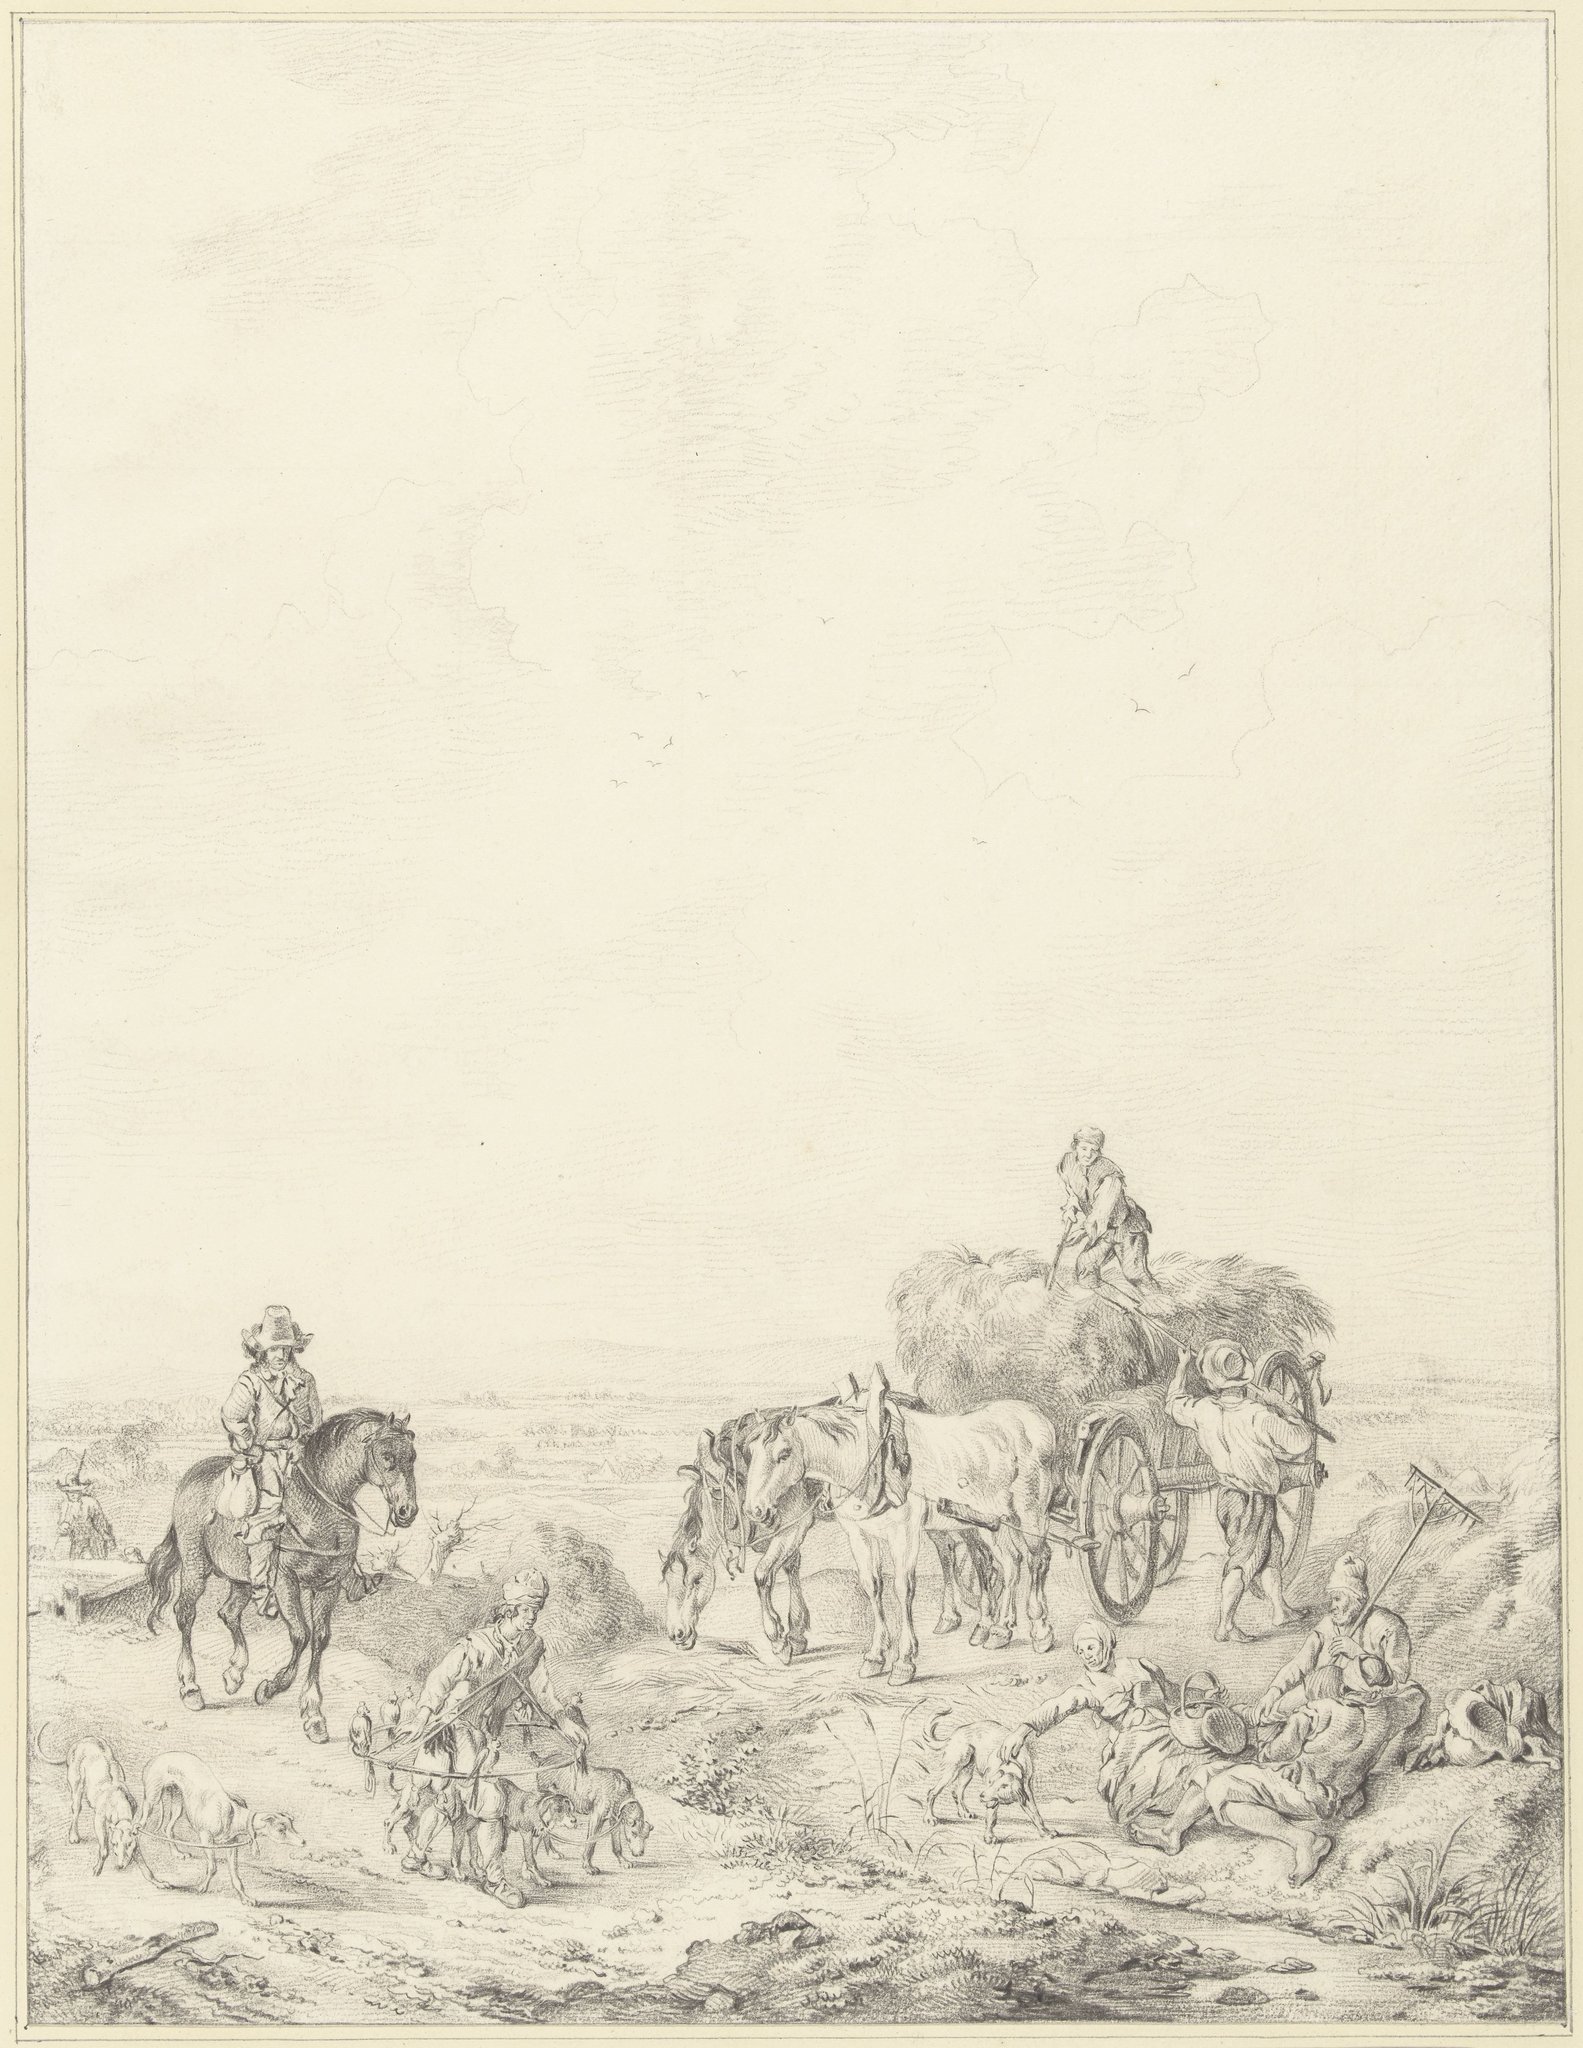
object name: drawing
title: Landschap met valkenier en landlieden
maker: jordanus hoorn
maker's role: draughtsman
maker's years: 1753-1833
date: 1763-1833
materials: chalk, paper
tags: bird hunting (+ hunting with falcon, hawk; falconry)